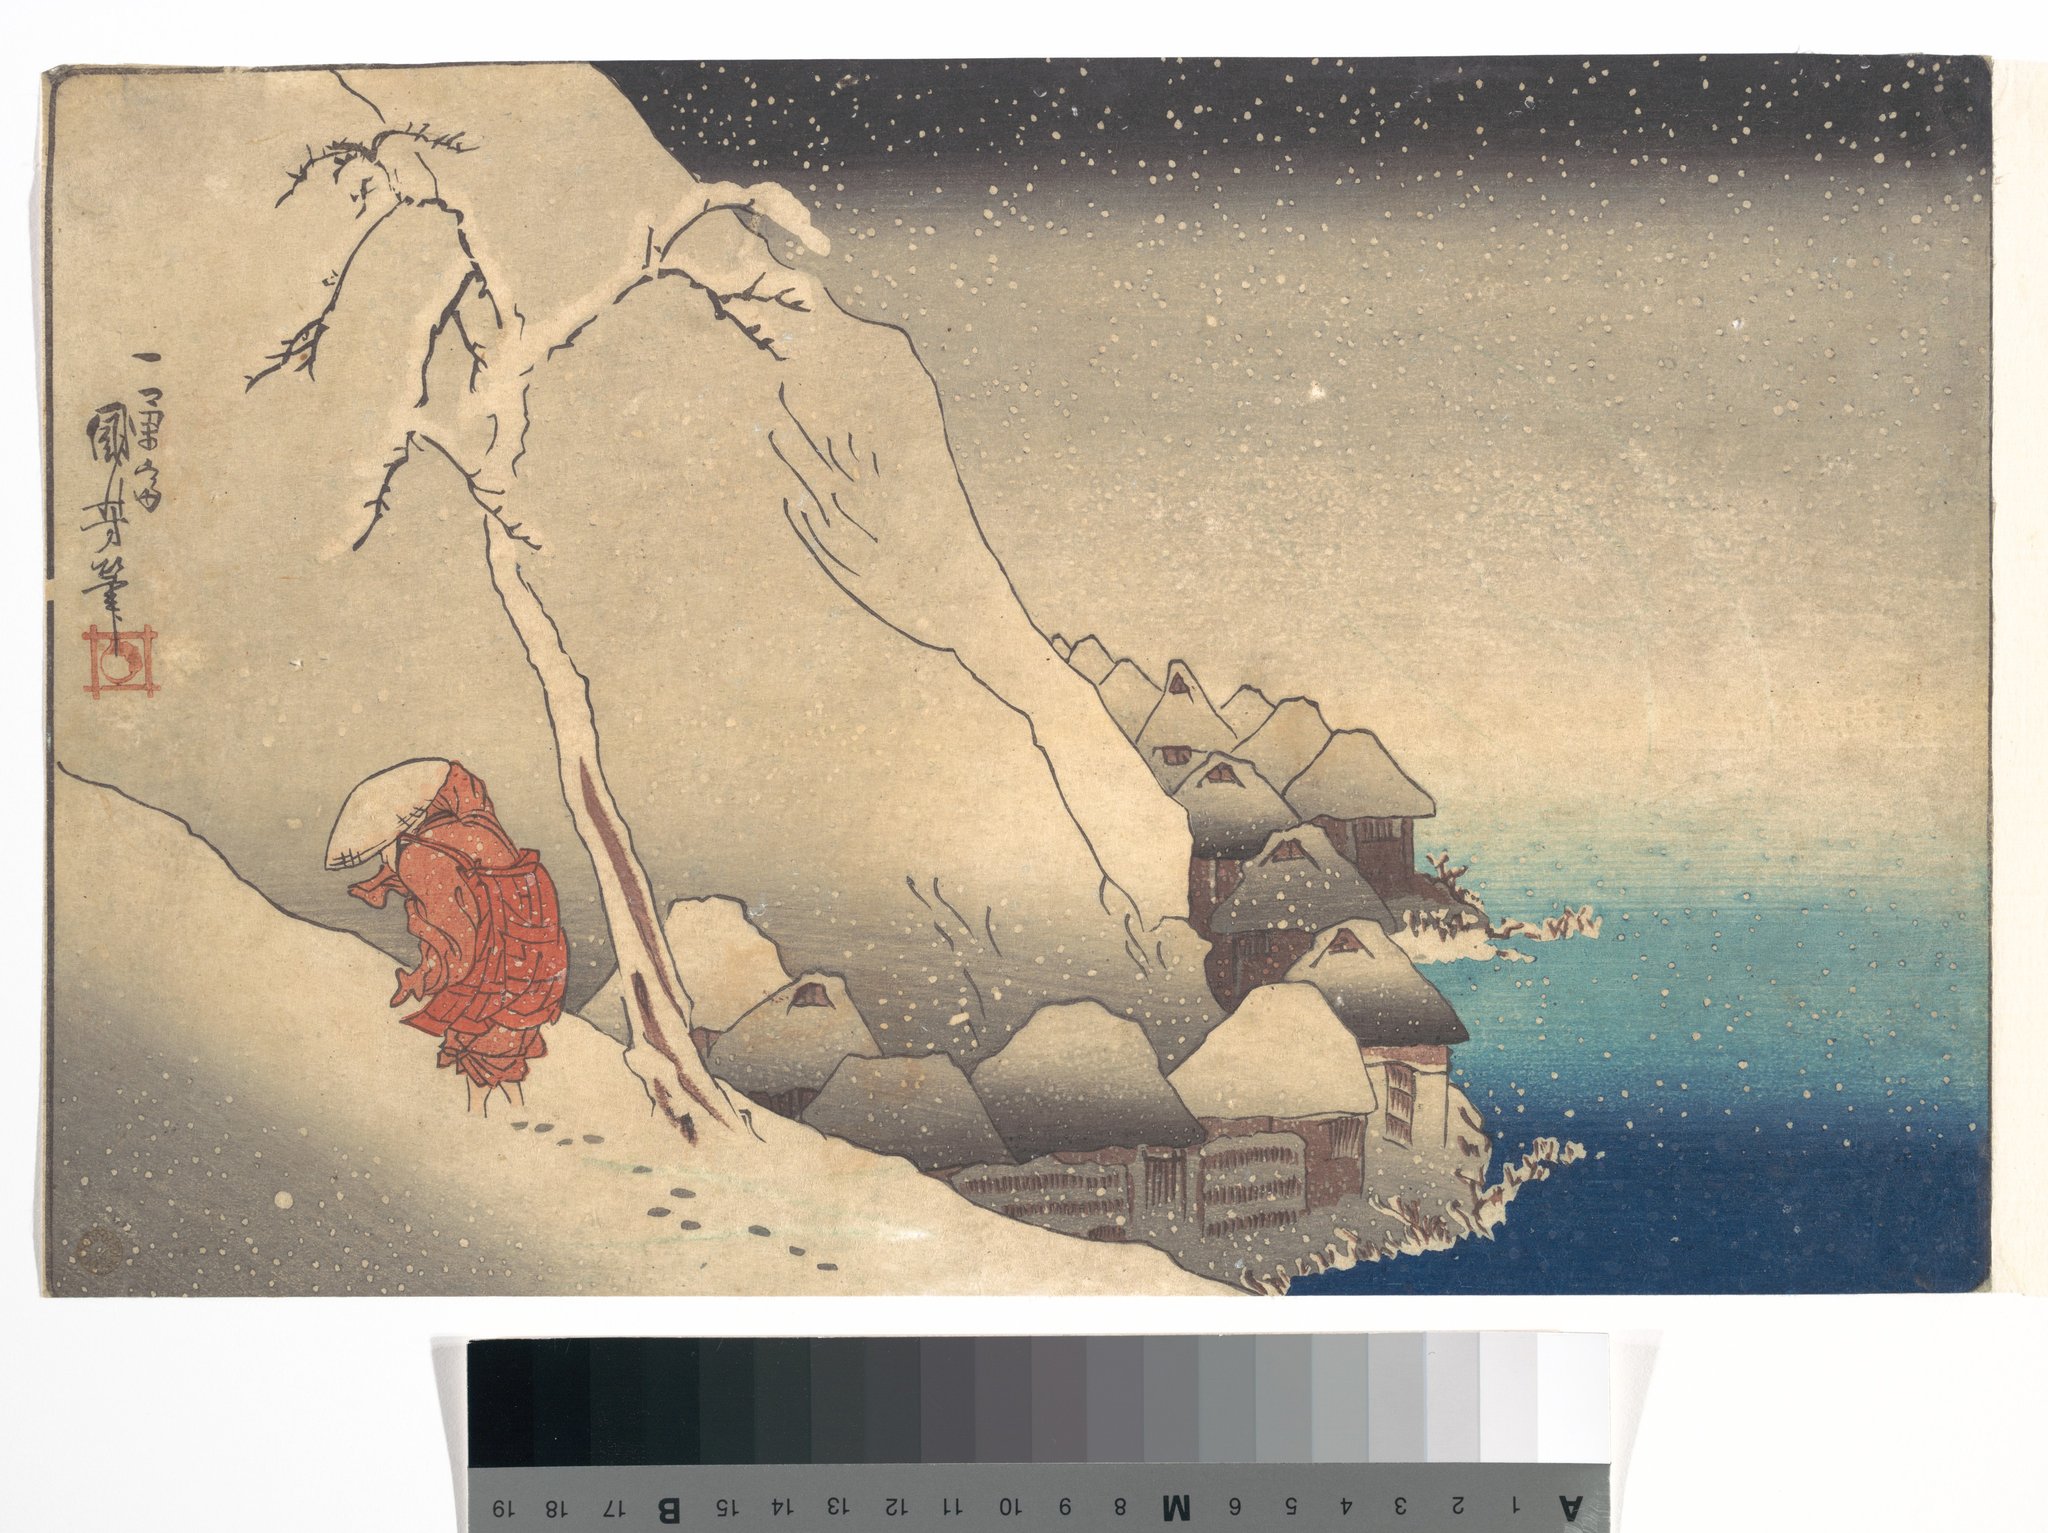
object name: print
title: Travelling in a Snowstorm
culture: japanese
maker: utagawa kuniyoshi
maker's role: artist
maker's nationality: japanese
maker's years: 1797-1861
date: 1830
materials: ink, paper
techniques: woodblock print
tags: houses,trees,snow